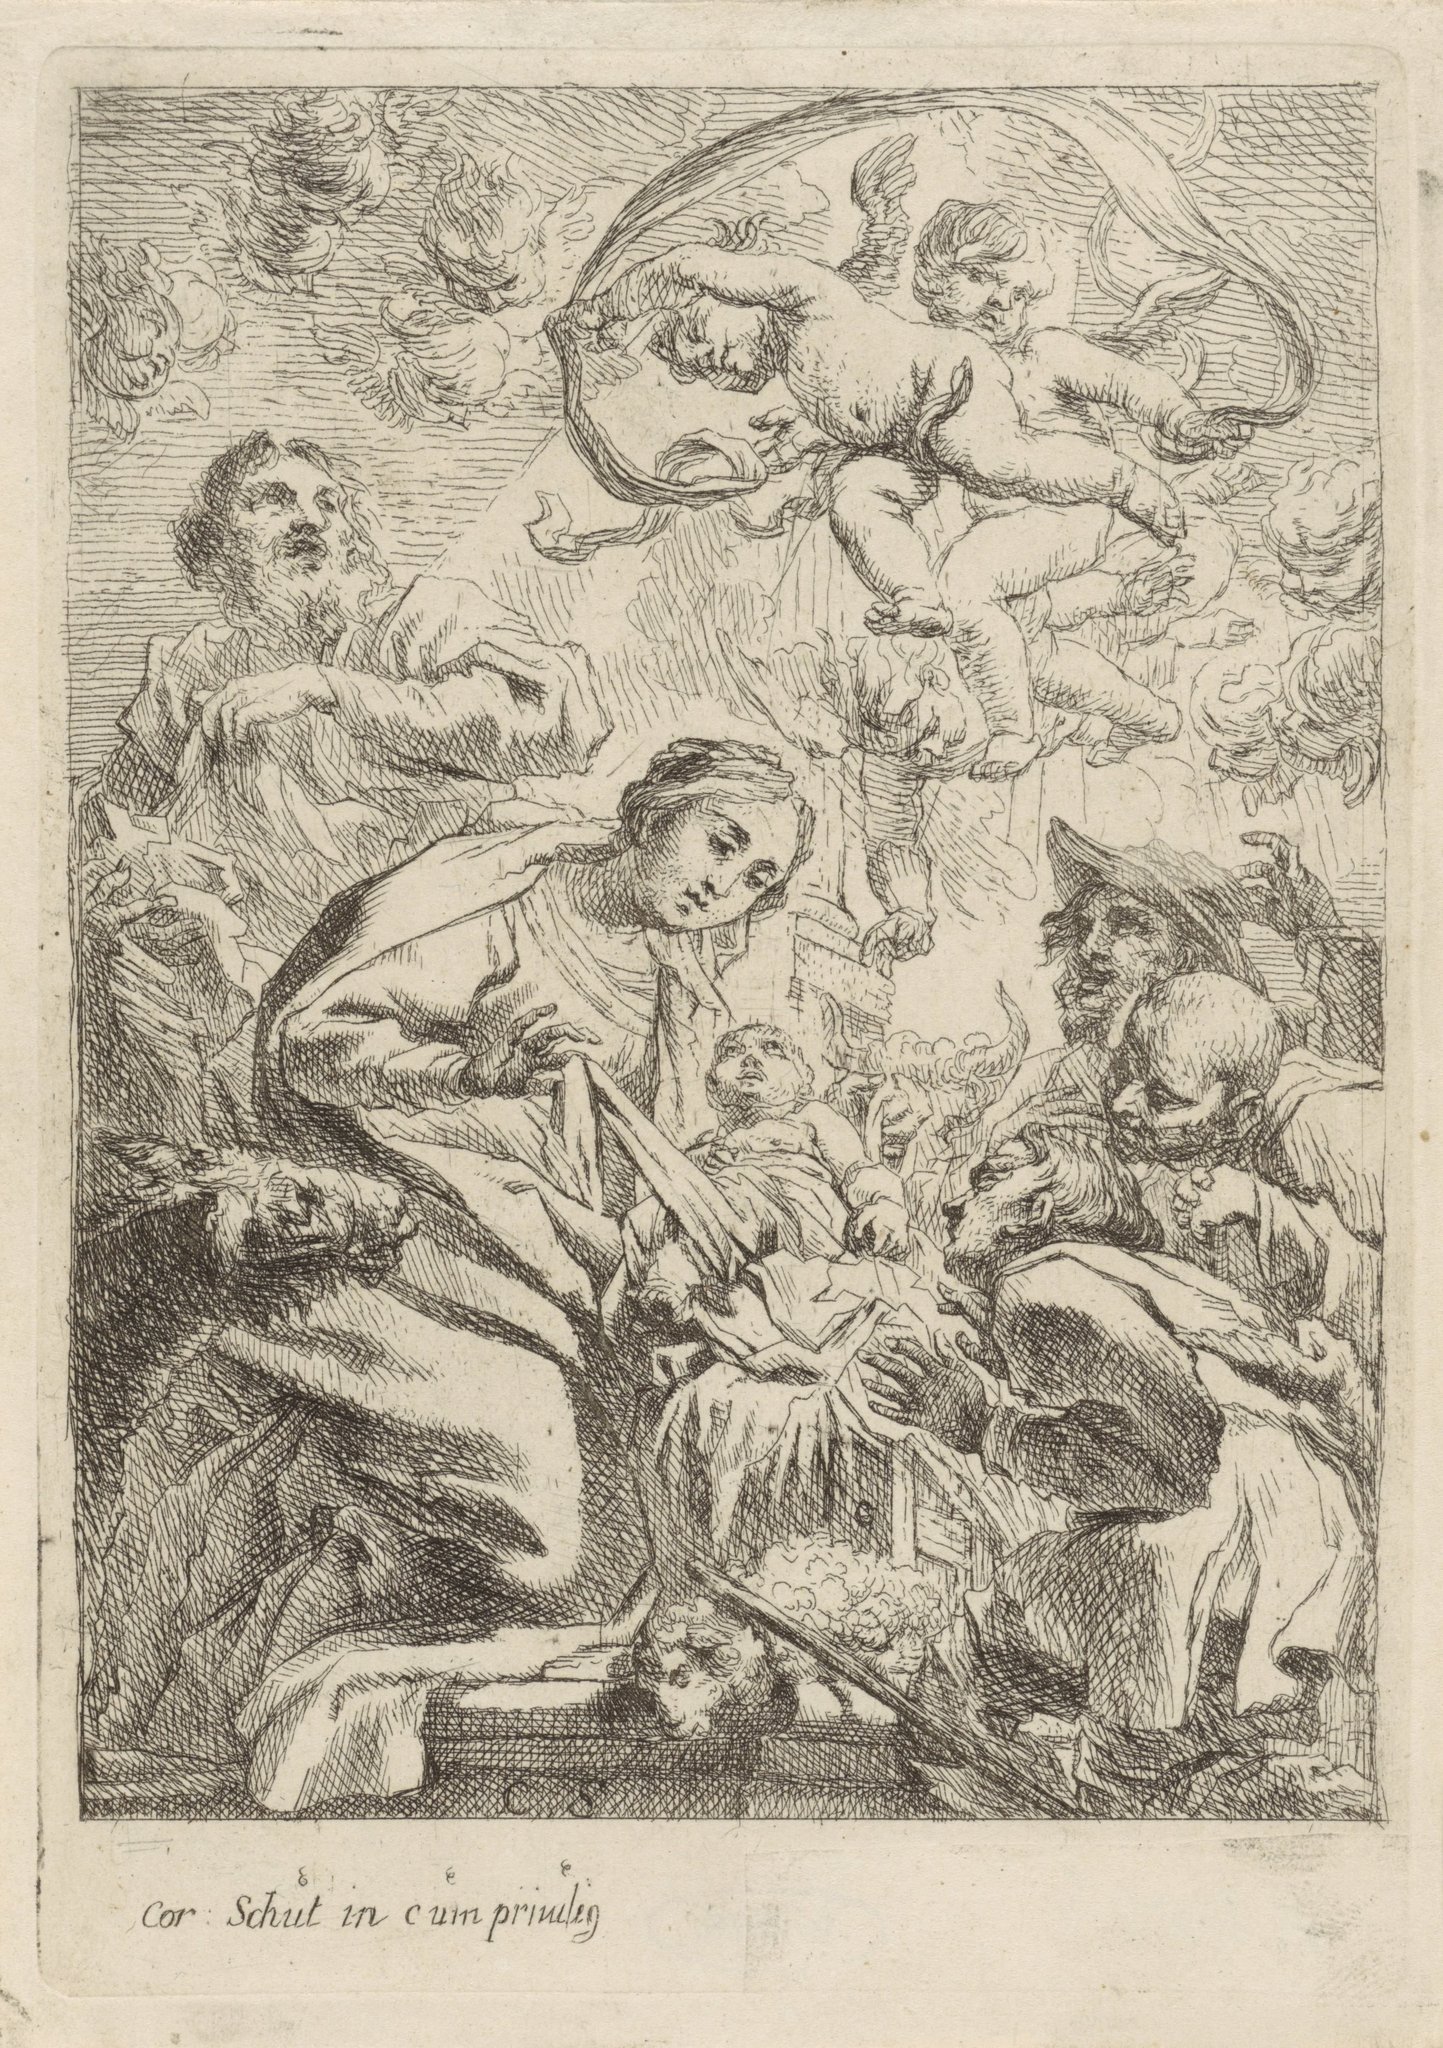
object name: print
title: Aanbidding door de herders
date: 1618-1655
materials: paper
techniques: etching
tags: adoration of the christ-child by the shepherds; mary and joseph present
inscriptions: collector's mark: Lugt 2228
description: Maria verschoont de windselen van het Christuskind. Josef staat achter haar en kijkt op naar enkele putti in de lucht. De herders knielen neer bij het kribje. Links de ezel.